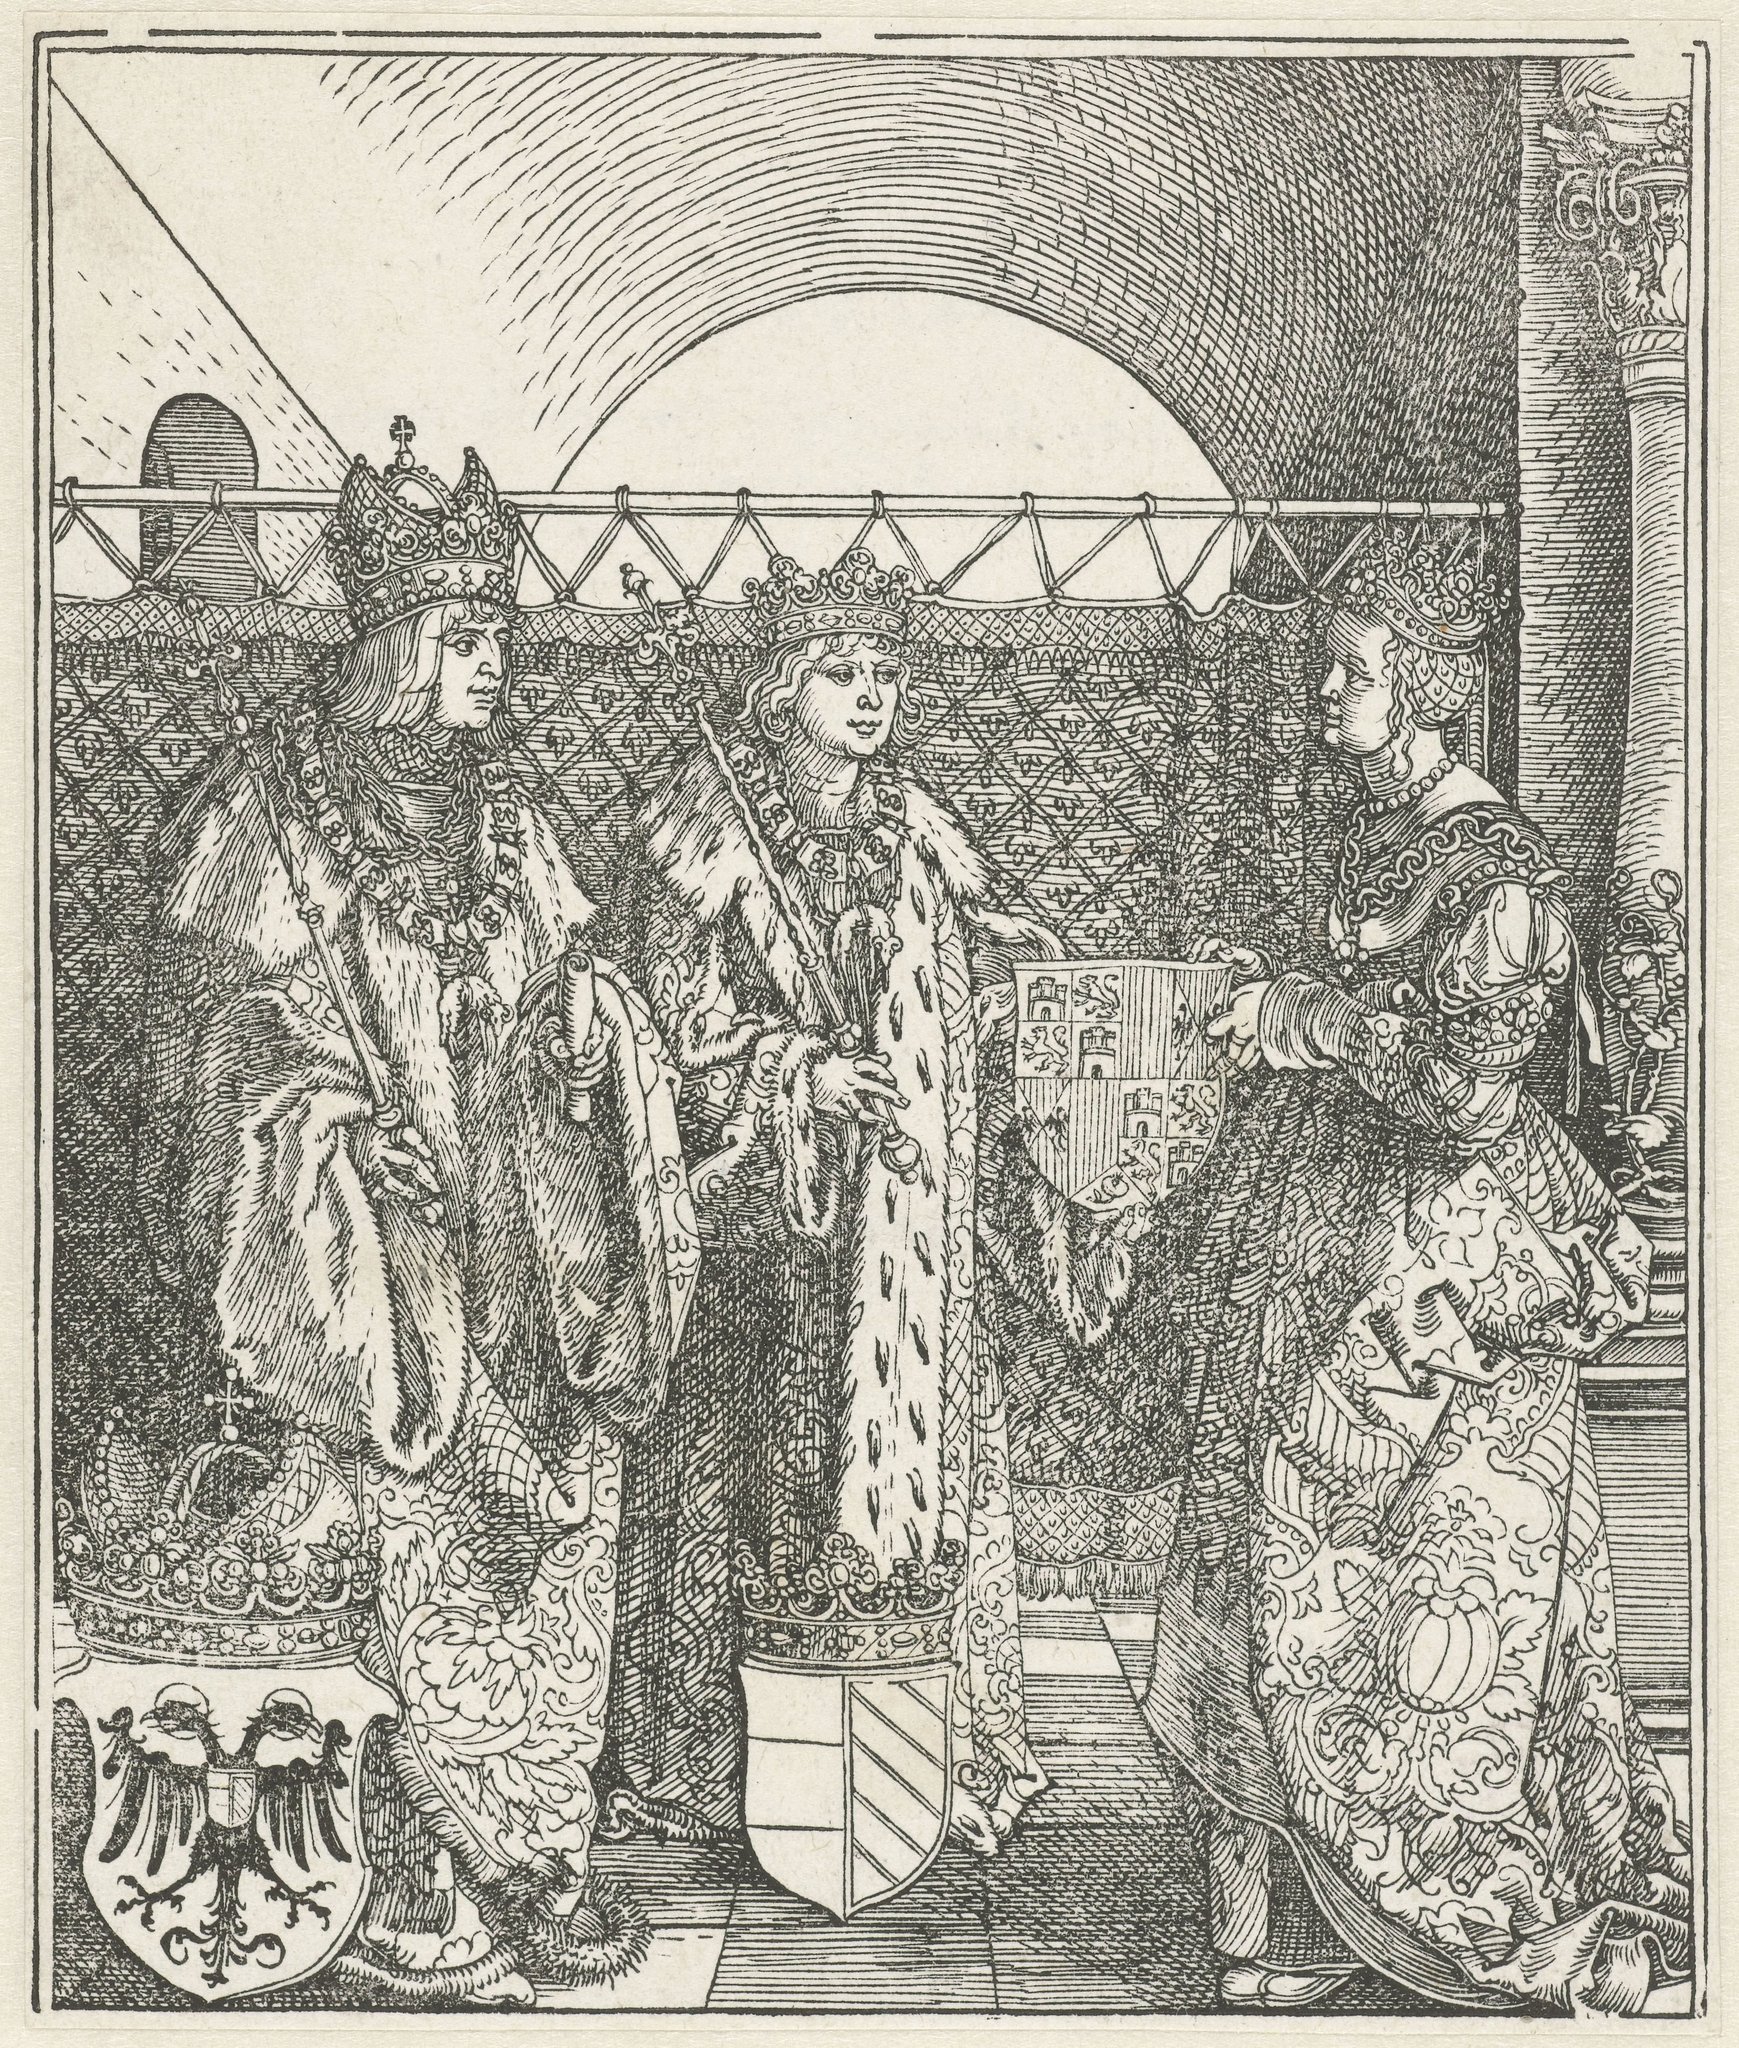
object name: print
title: Triomfboog van keizer Maximiliaan I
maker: albrecht dürer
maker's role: draughtsman, painter, print maker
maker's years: 1471-1528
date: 1515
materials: paper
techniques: woodcut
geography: nuremberg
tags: maximilian i (holy roman emperor), filips de schone (hertog van bourgondië), marriage, married couple, 'matrimonium', armorial bearing, heraldry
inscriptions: collector's mark: Lugt 240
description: Voor een gordijn staat Maximiliaan bij zijn zoon Filips de Schone en zijn schoondochter Johanna van Castilië, die samen een wapenschild vasthouden. Links naast Maximiliaan is nog een wapenschild zichtbaar, en bij Filips' voeten nog één. Detail van de triomfboog van keizer Maximiliaan I.